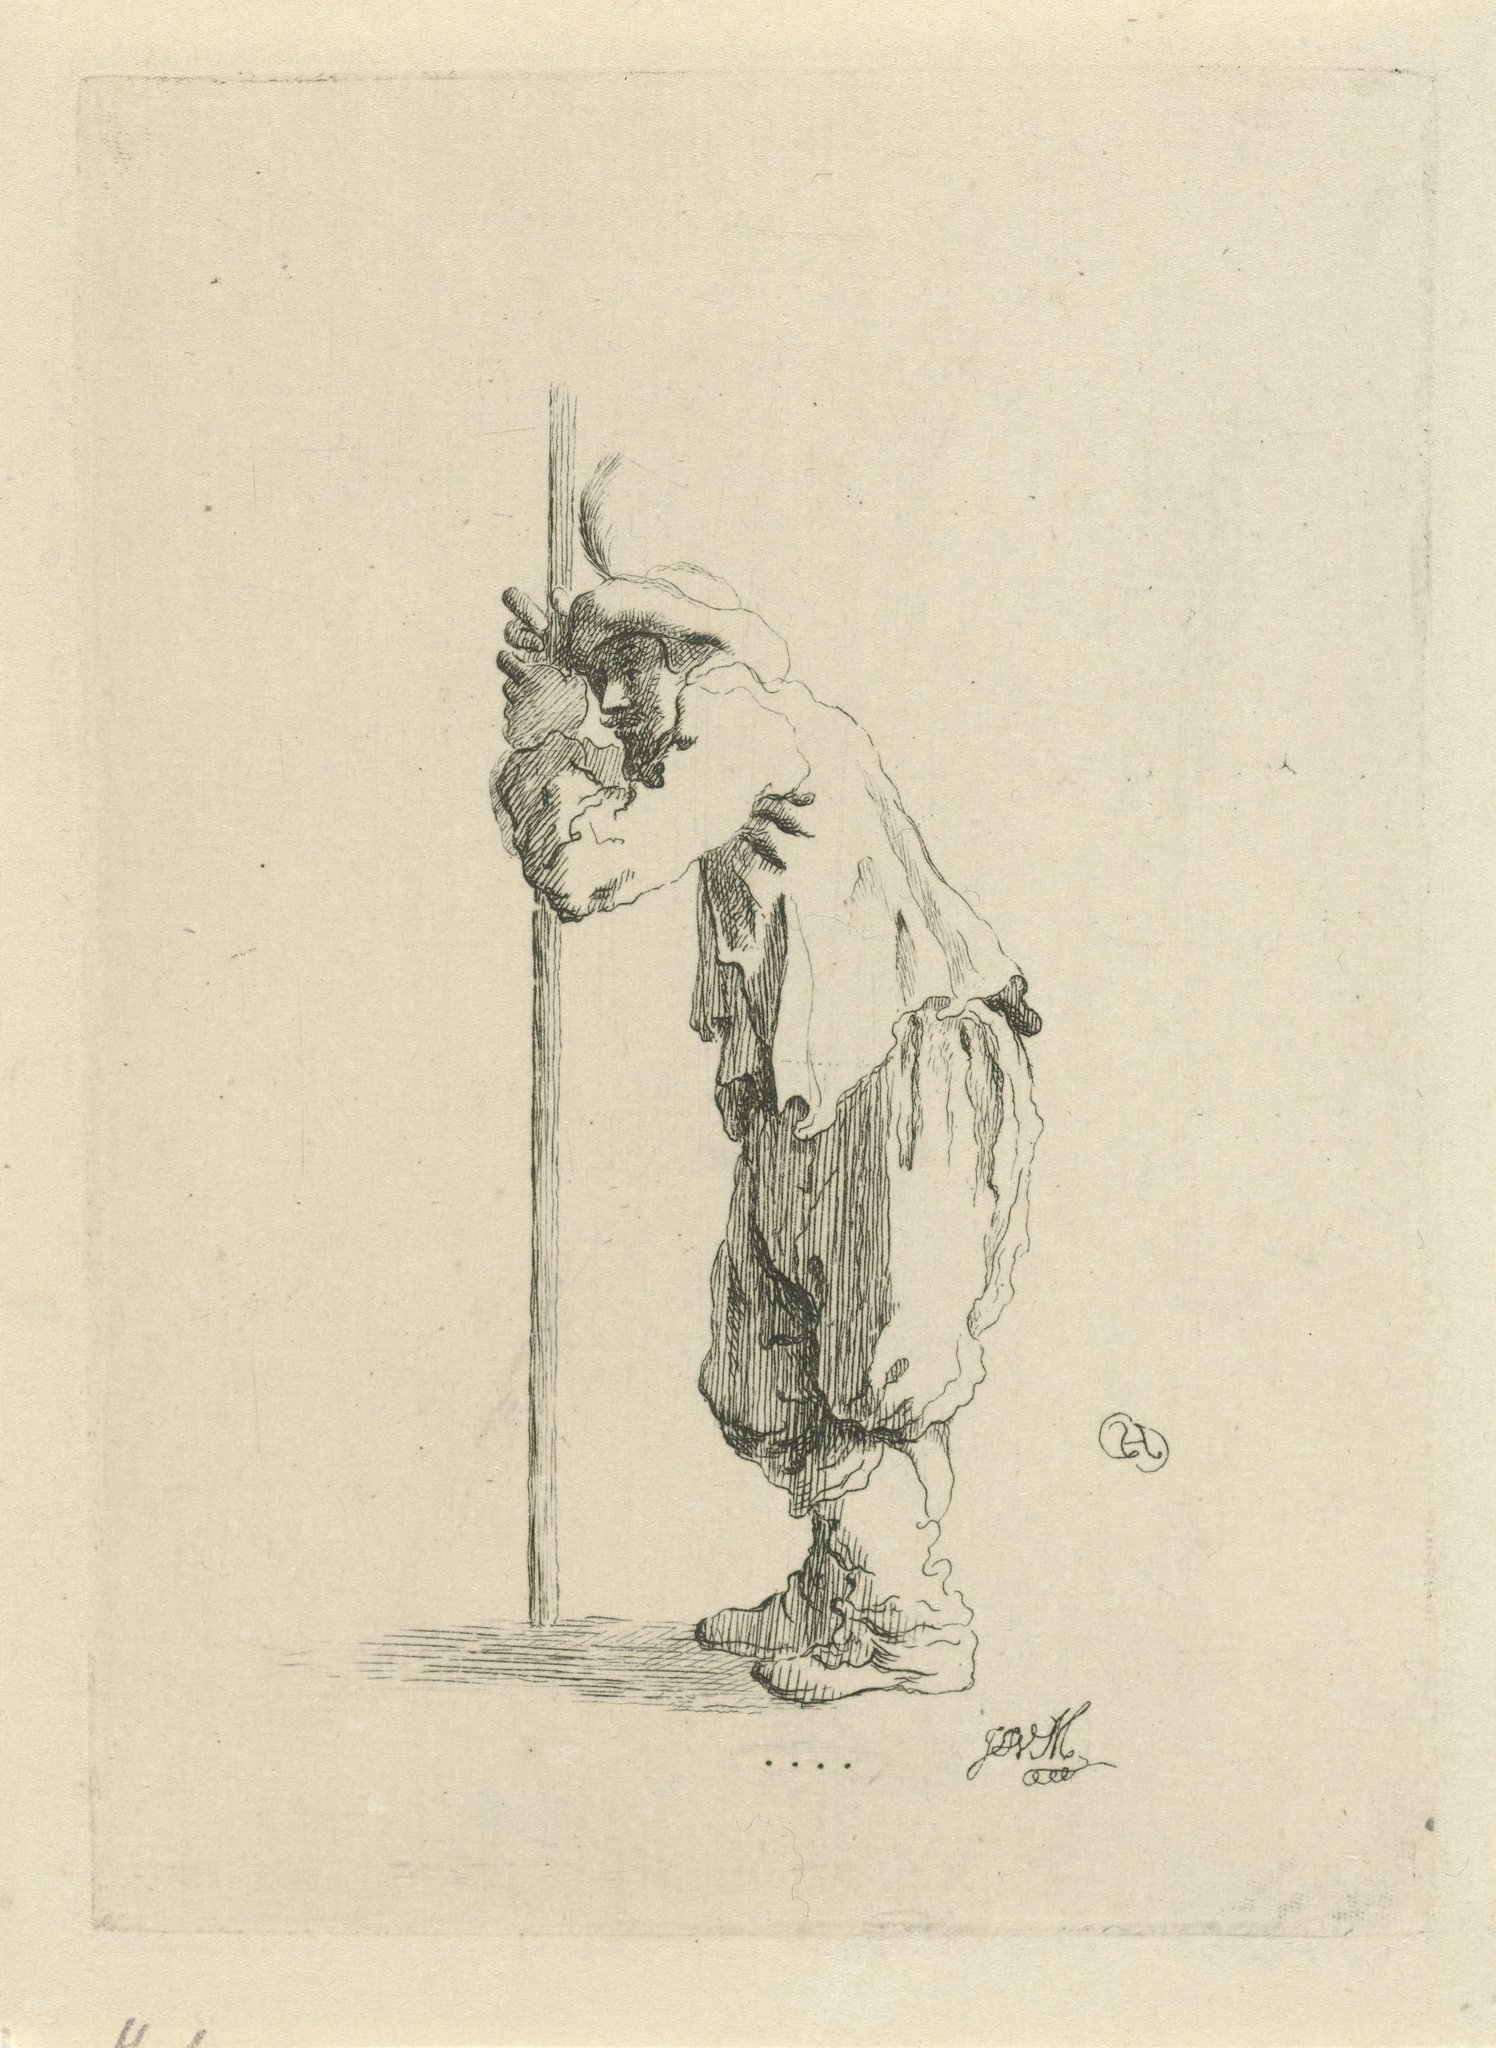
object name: print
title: Man leunend op een stok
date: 1771-1802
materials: paper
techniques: etching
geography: netherlands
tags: walking-stick, staff, leaning figure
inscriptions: collector's mark: Lugt 2227